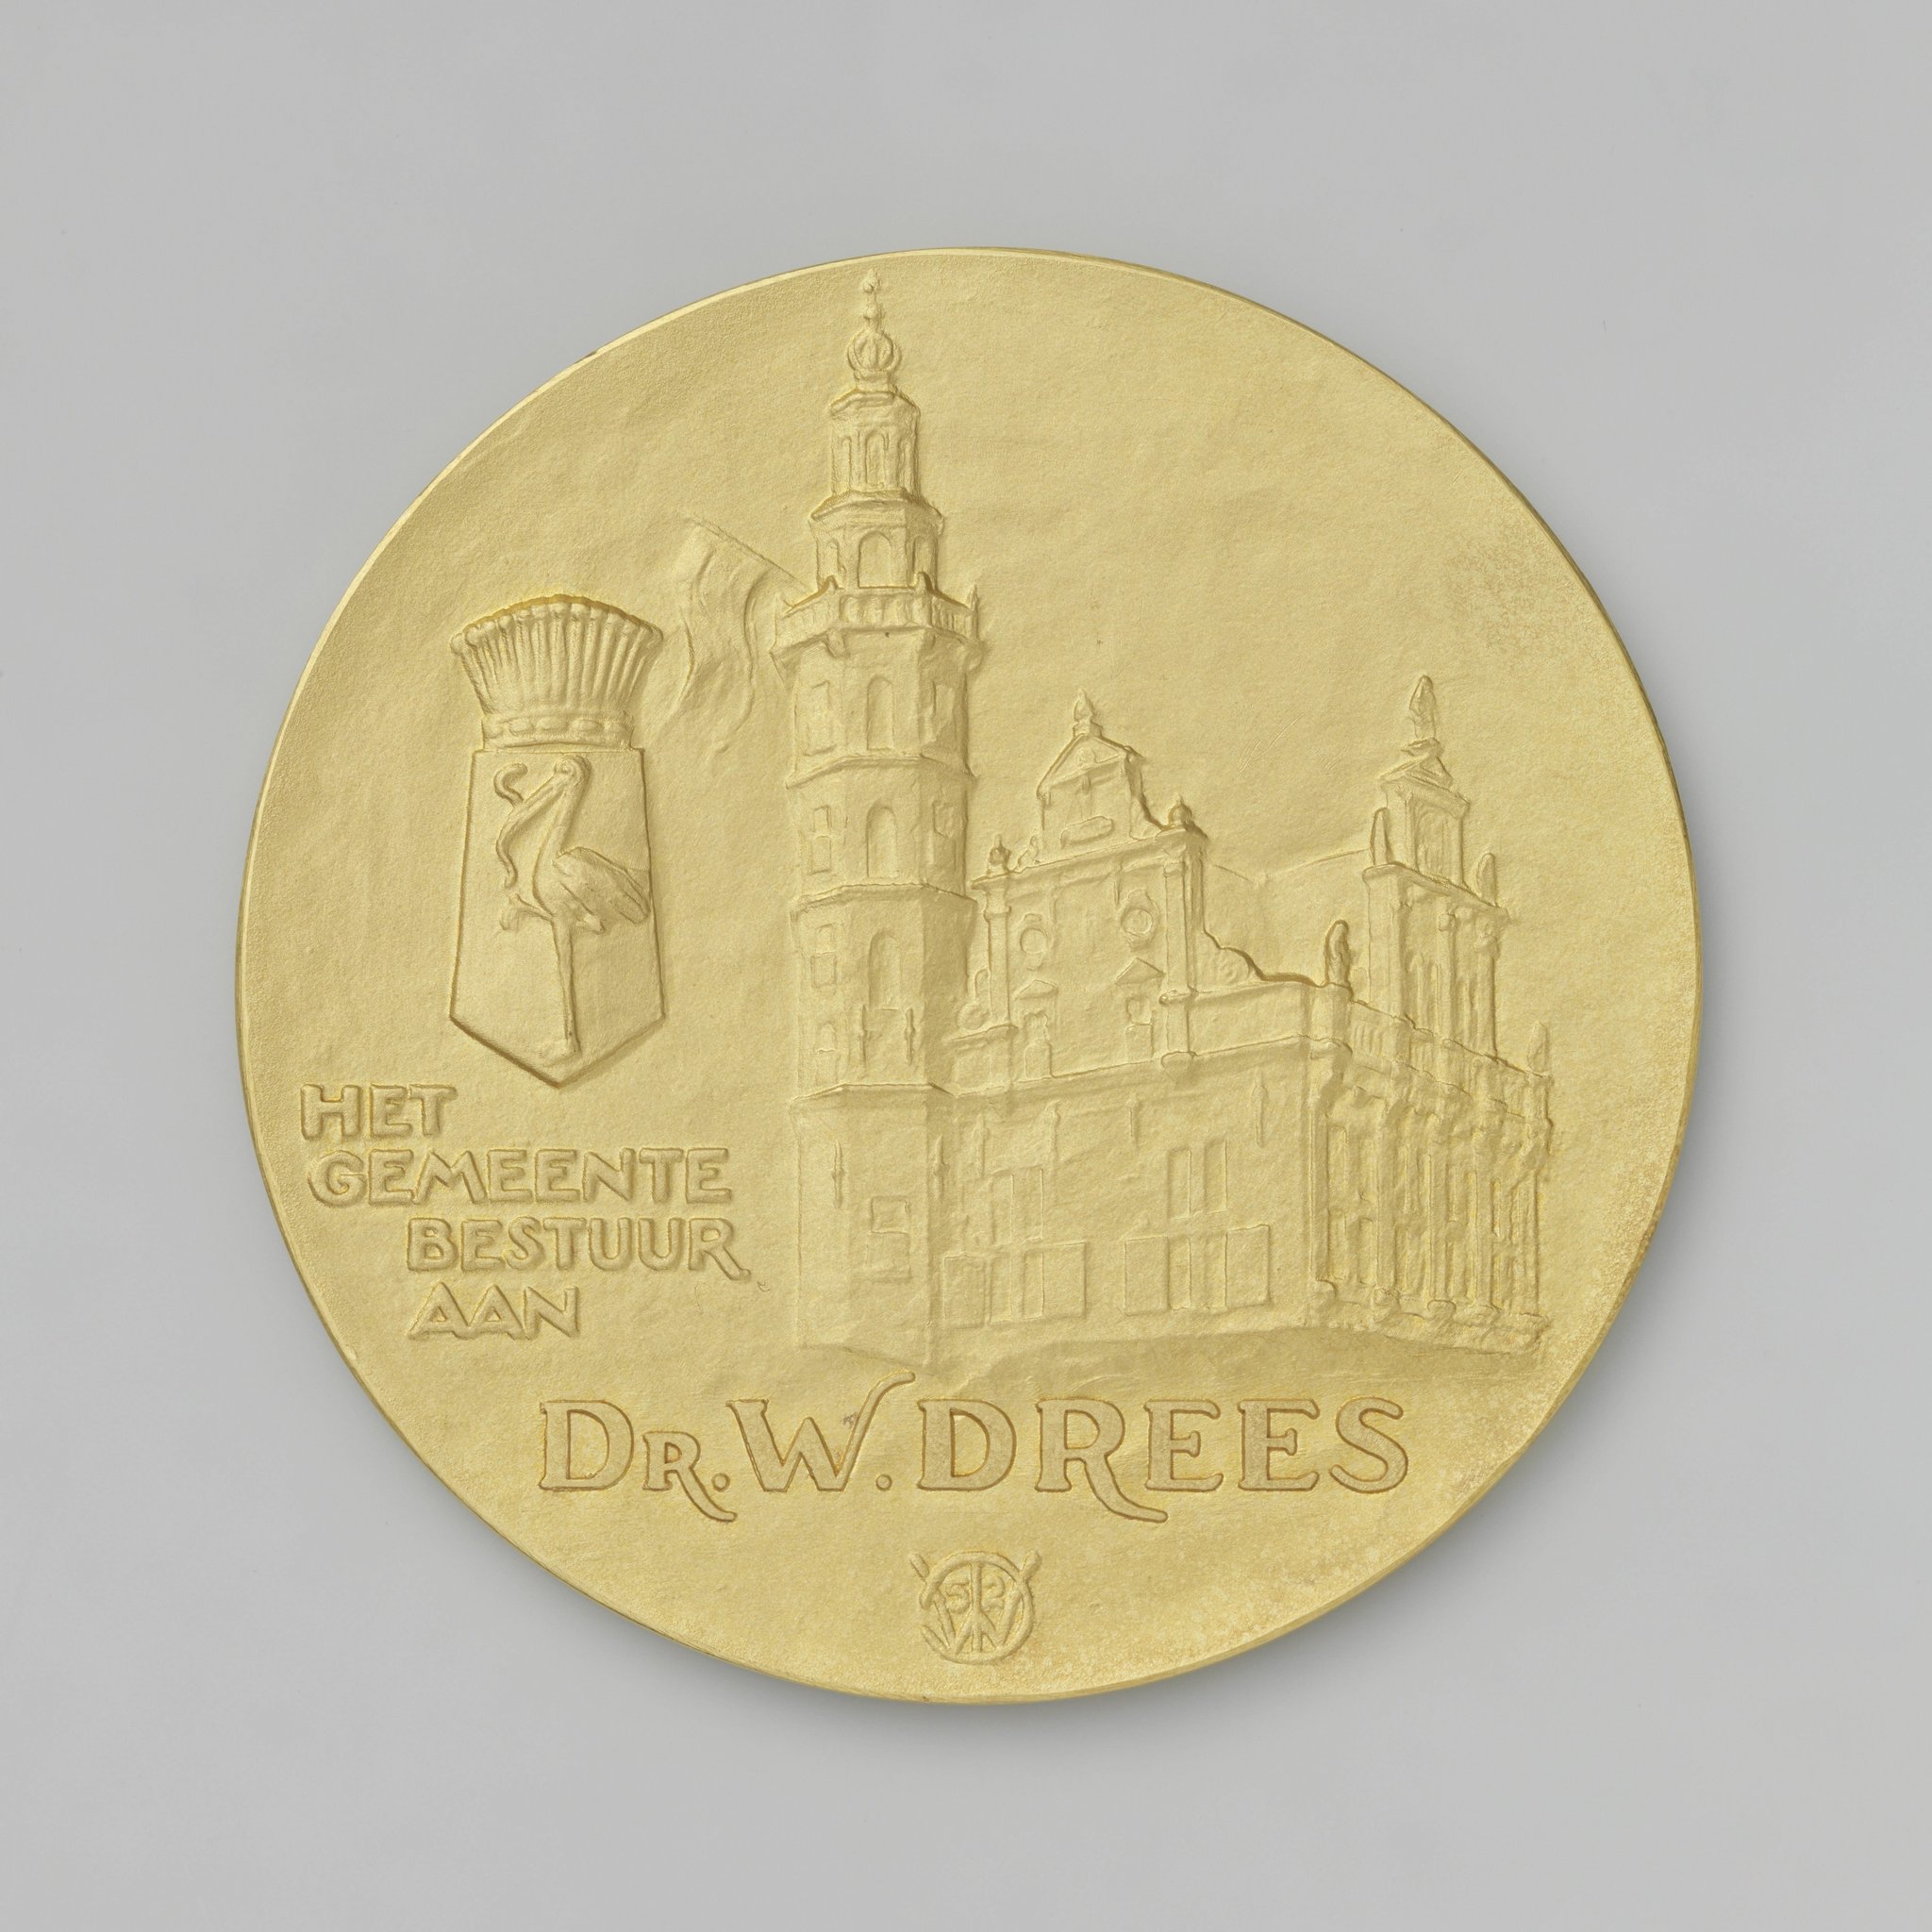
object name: honorary medal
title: Honorary Medal of the Municipality of The Hague Awarded to Willem Drees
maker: dirk wolbers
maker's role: designer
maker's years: 1890-1957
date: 1952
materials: gold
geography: netherlands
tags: amsterdam, the hague, willem drees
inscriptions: inscription: ‘HET GEMEENTEBESTUUR AAN DR. W. DREES WD 52’, inscription: ‘'S GRAVENHAGE CRESCAT’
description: People who have performed a heroic deed or reached the end of a long career are sometimes awarded a medal as a token of esteem and gratitude. Often these are made of gold. Especially in the seventeenth century, gold medals with their chains were literally a reward. They were subsequently melted down and converted into money, which is why so few have survived.